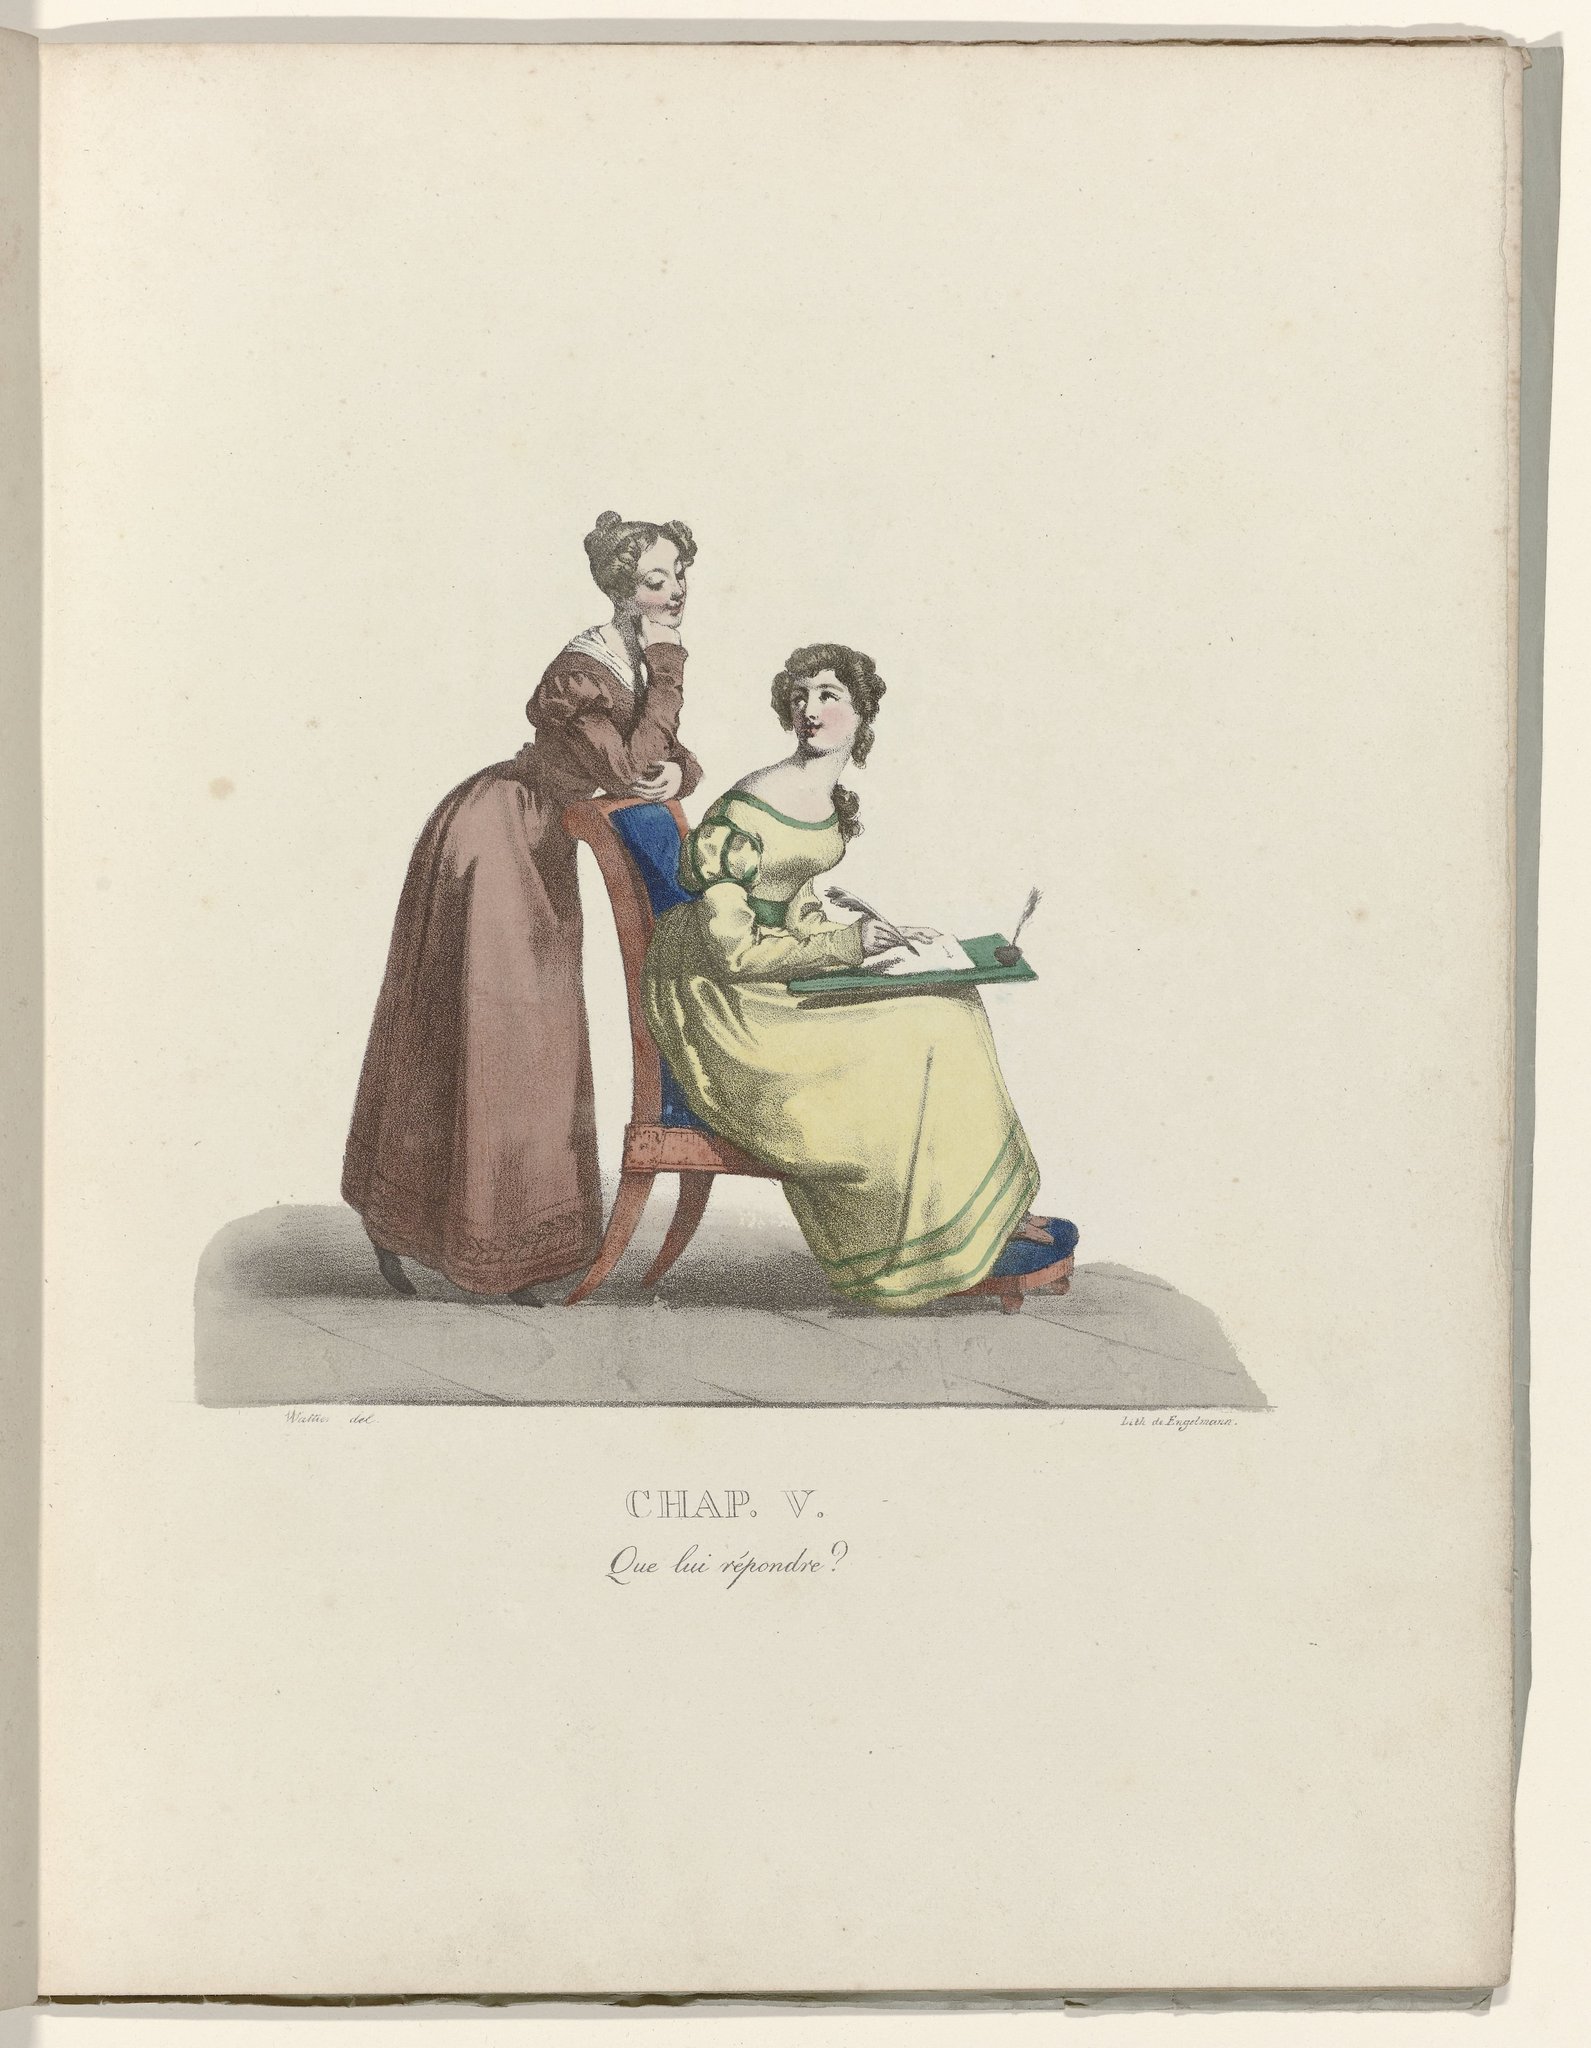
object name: fashion print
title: La Né d'une Modiste, 1828 : Chap. V: Que lui répondre ?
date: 1828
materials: paper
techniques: hand coloring, lithograph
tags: fashion plates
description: Jonge vrouw, zittend met schrijfblok op schoot. Een andere vrouw staat achter haar.